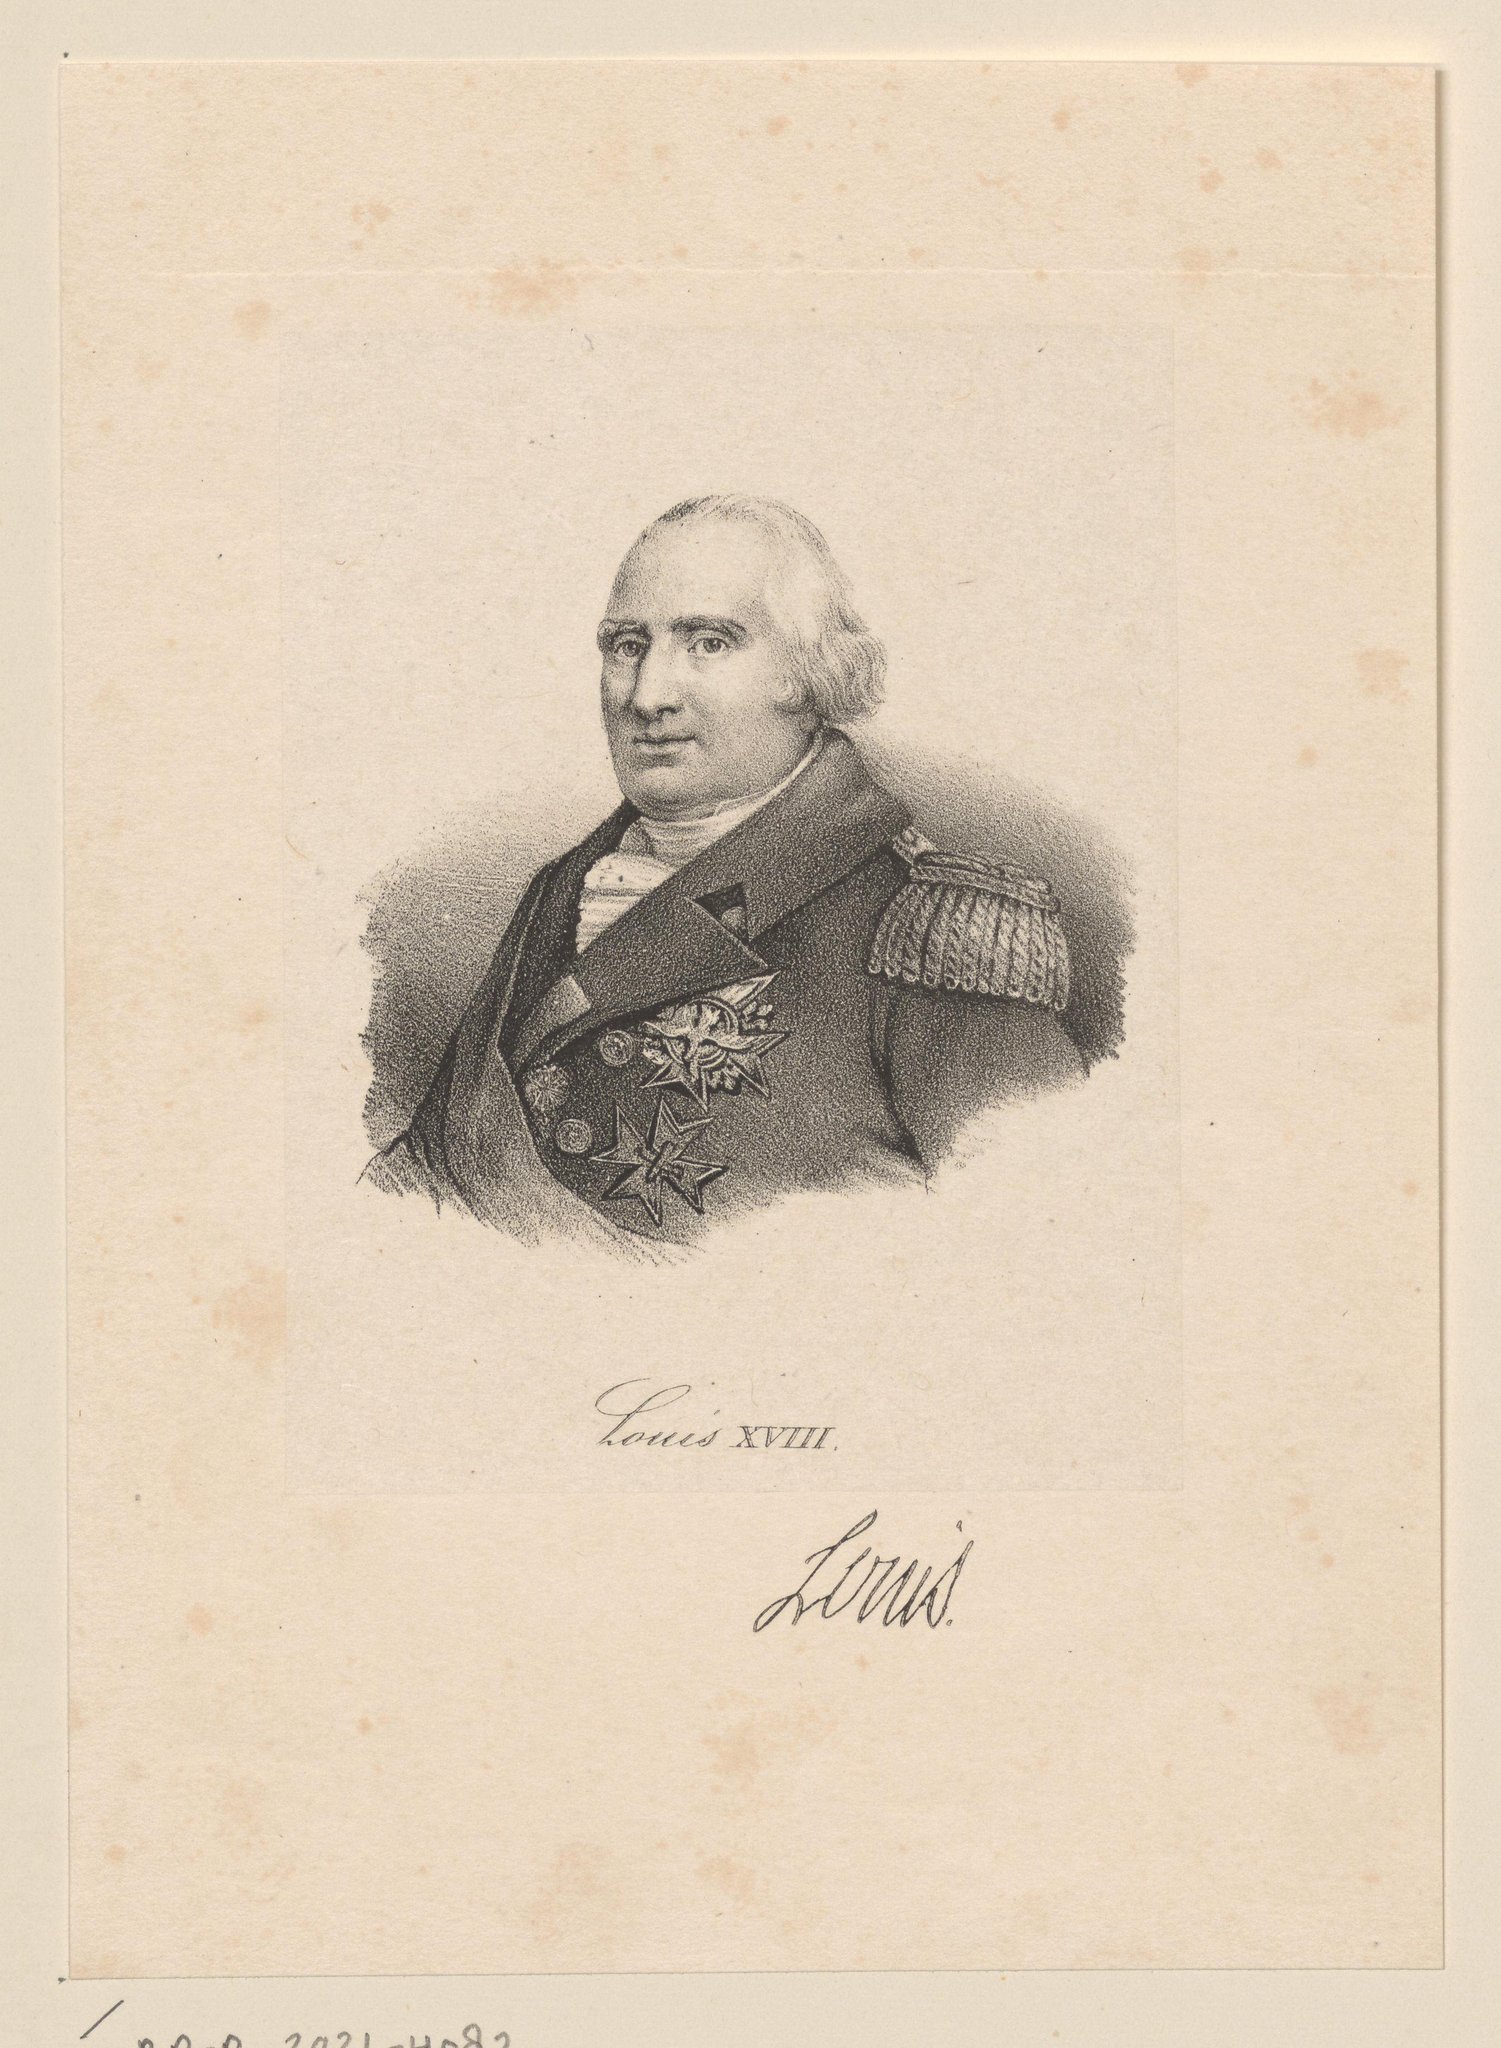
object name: print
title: Portret van Lodewijk XVIII van Frankrijk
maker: Anonymous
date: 1814-1850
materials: paper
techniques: lithograph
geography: france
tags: paris, lodewijk xviii (koning van frankrijk), historical persons, king